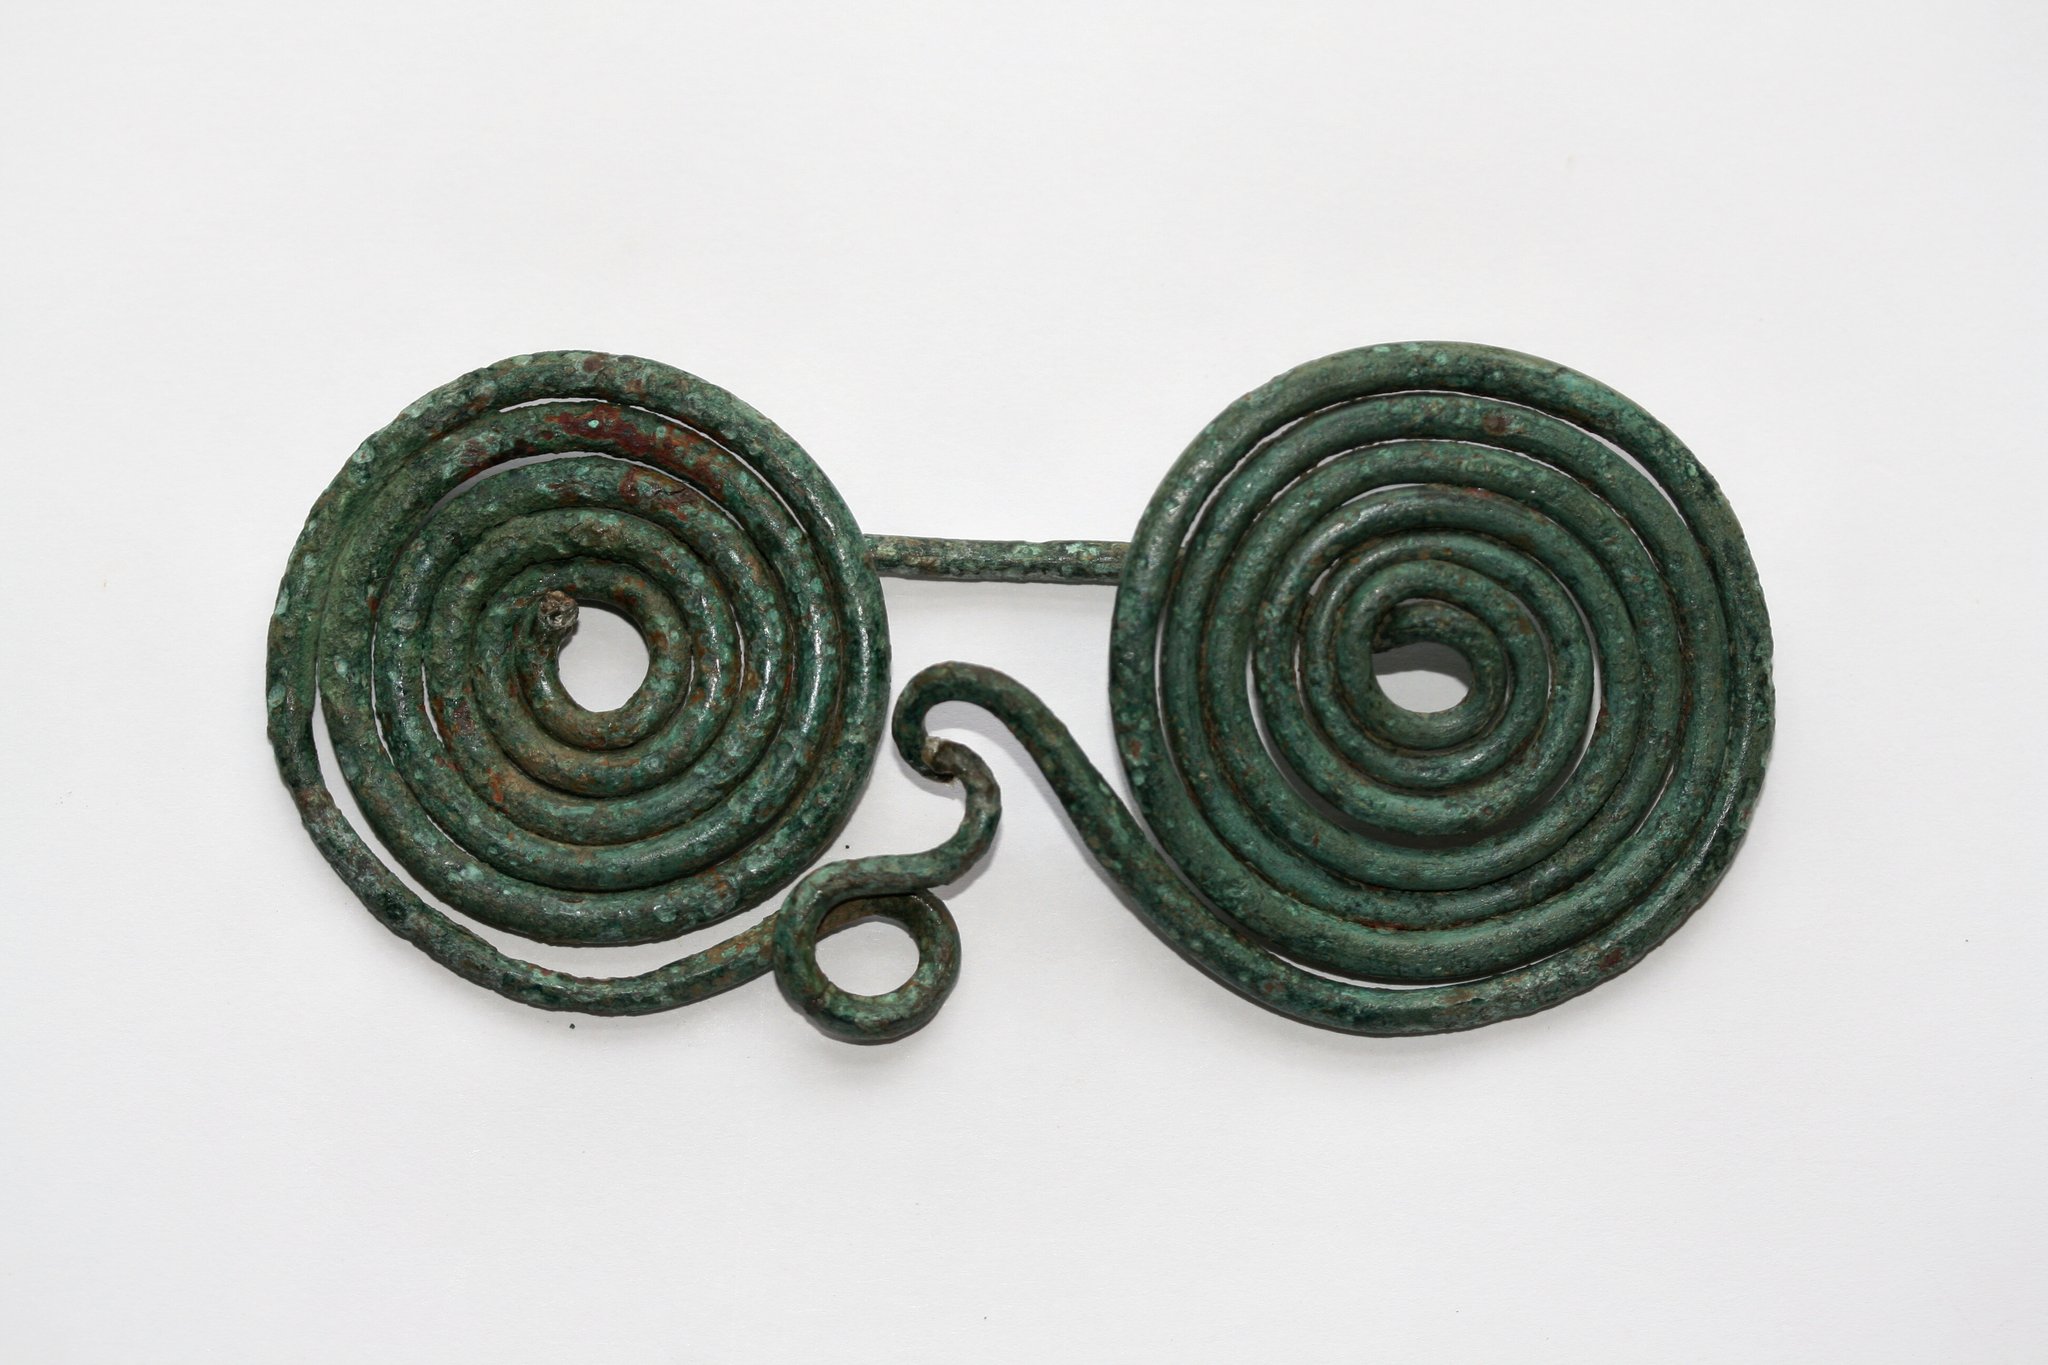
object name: brooch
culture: german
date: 800-701 BCE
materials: copper alloy